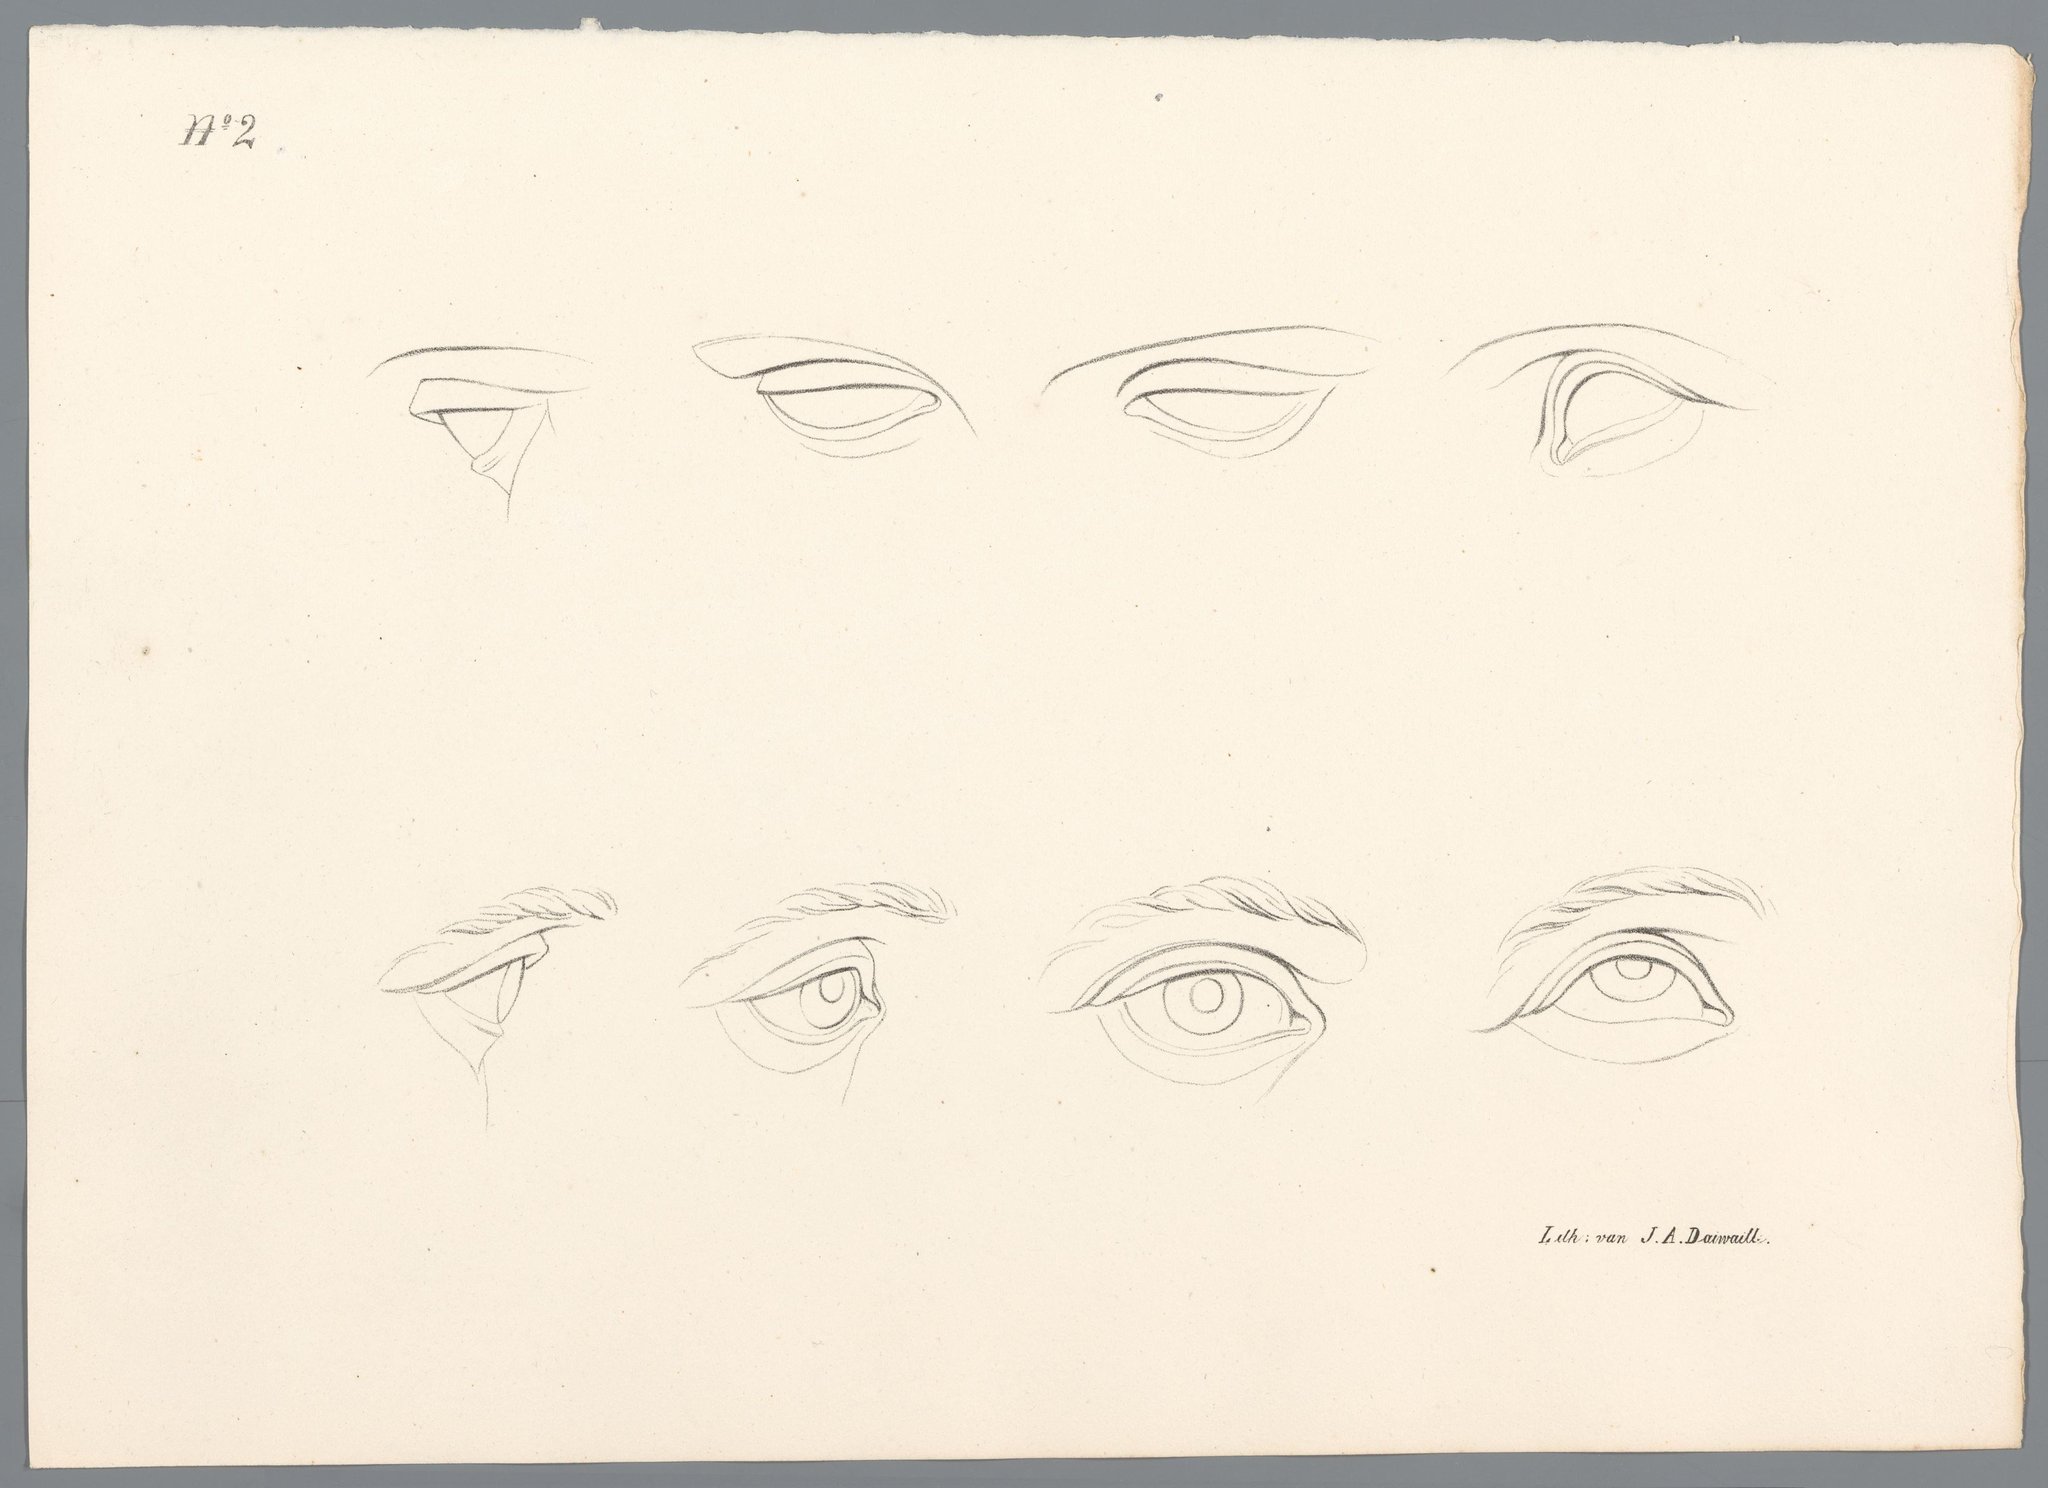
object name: print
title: Beeld-studien voor Eerstbeginnende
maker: jean augustin daiwaille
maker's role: draughtsman, print maker, printer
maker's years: 1786-1850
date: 1820-1826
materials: paper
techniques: lithograph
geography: amsterdam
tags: eyes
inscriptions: collector's mark: Lugt 2228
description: De ogen op de bovenste rij hebben geen pupillen. De ogen op de onderste rij hebben pupillen en wenkbrauwen. Genummerd linksboven: 'No. 2'. Deze prent maakt deel uit van een omslag met veertien prenten.